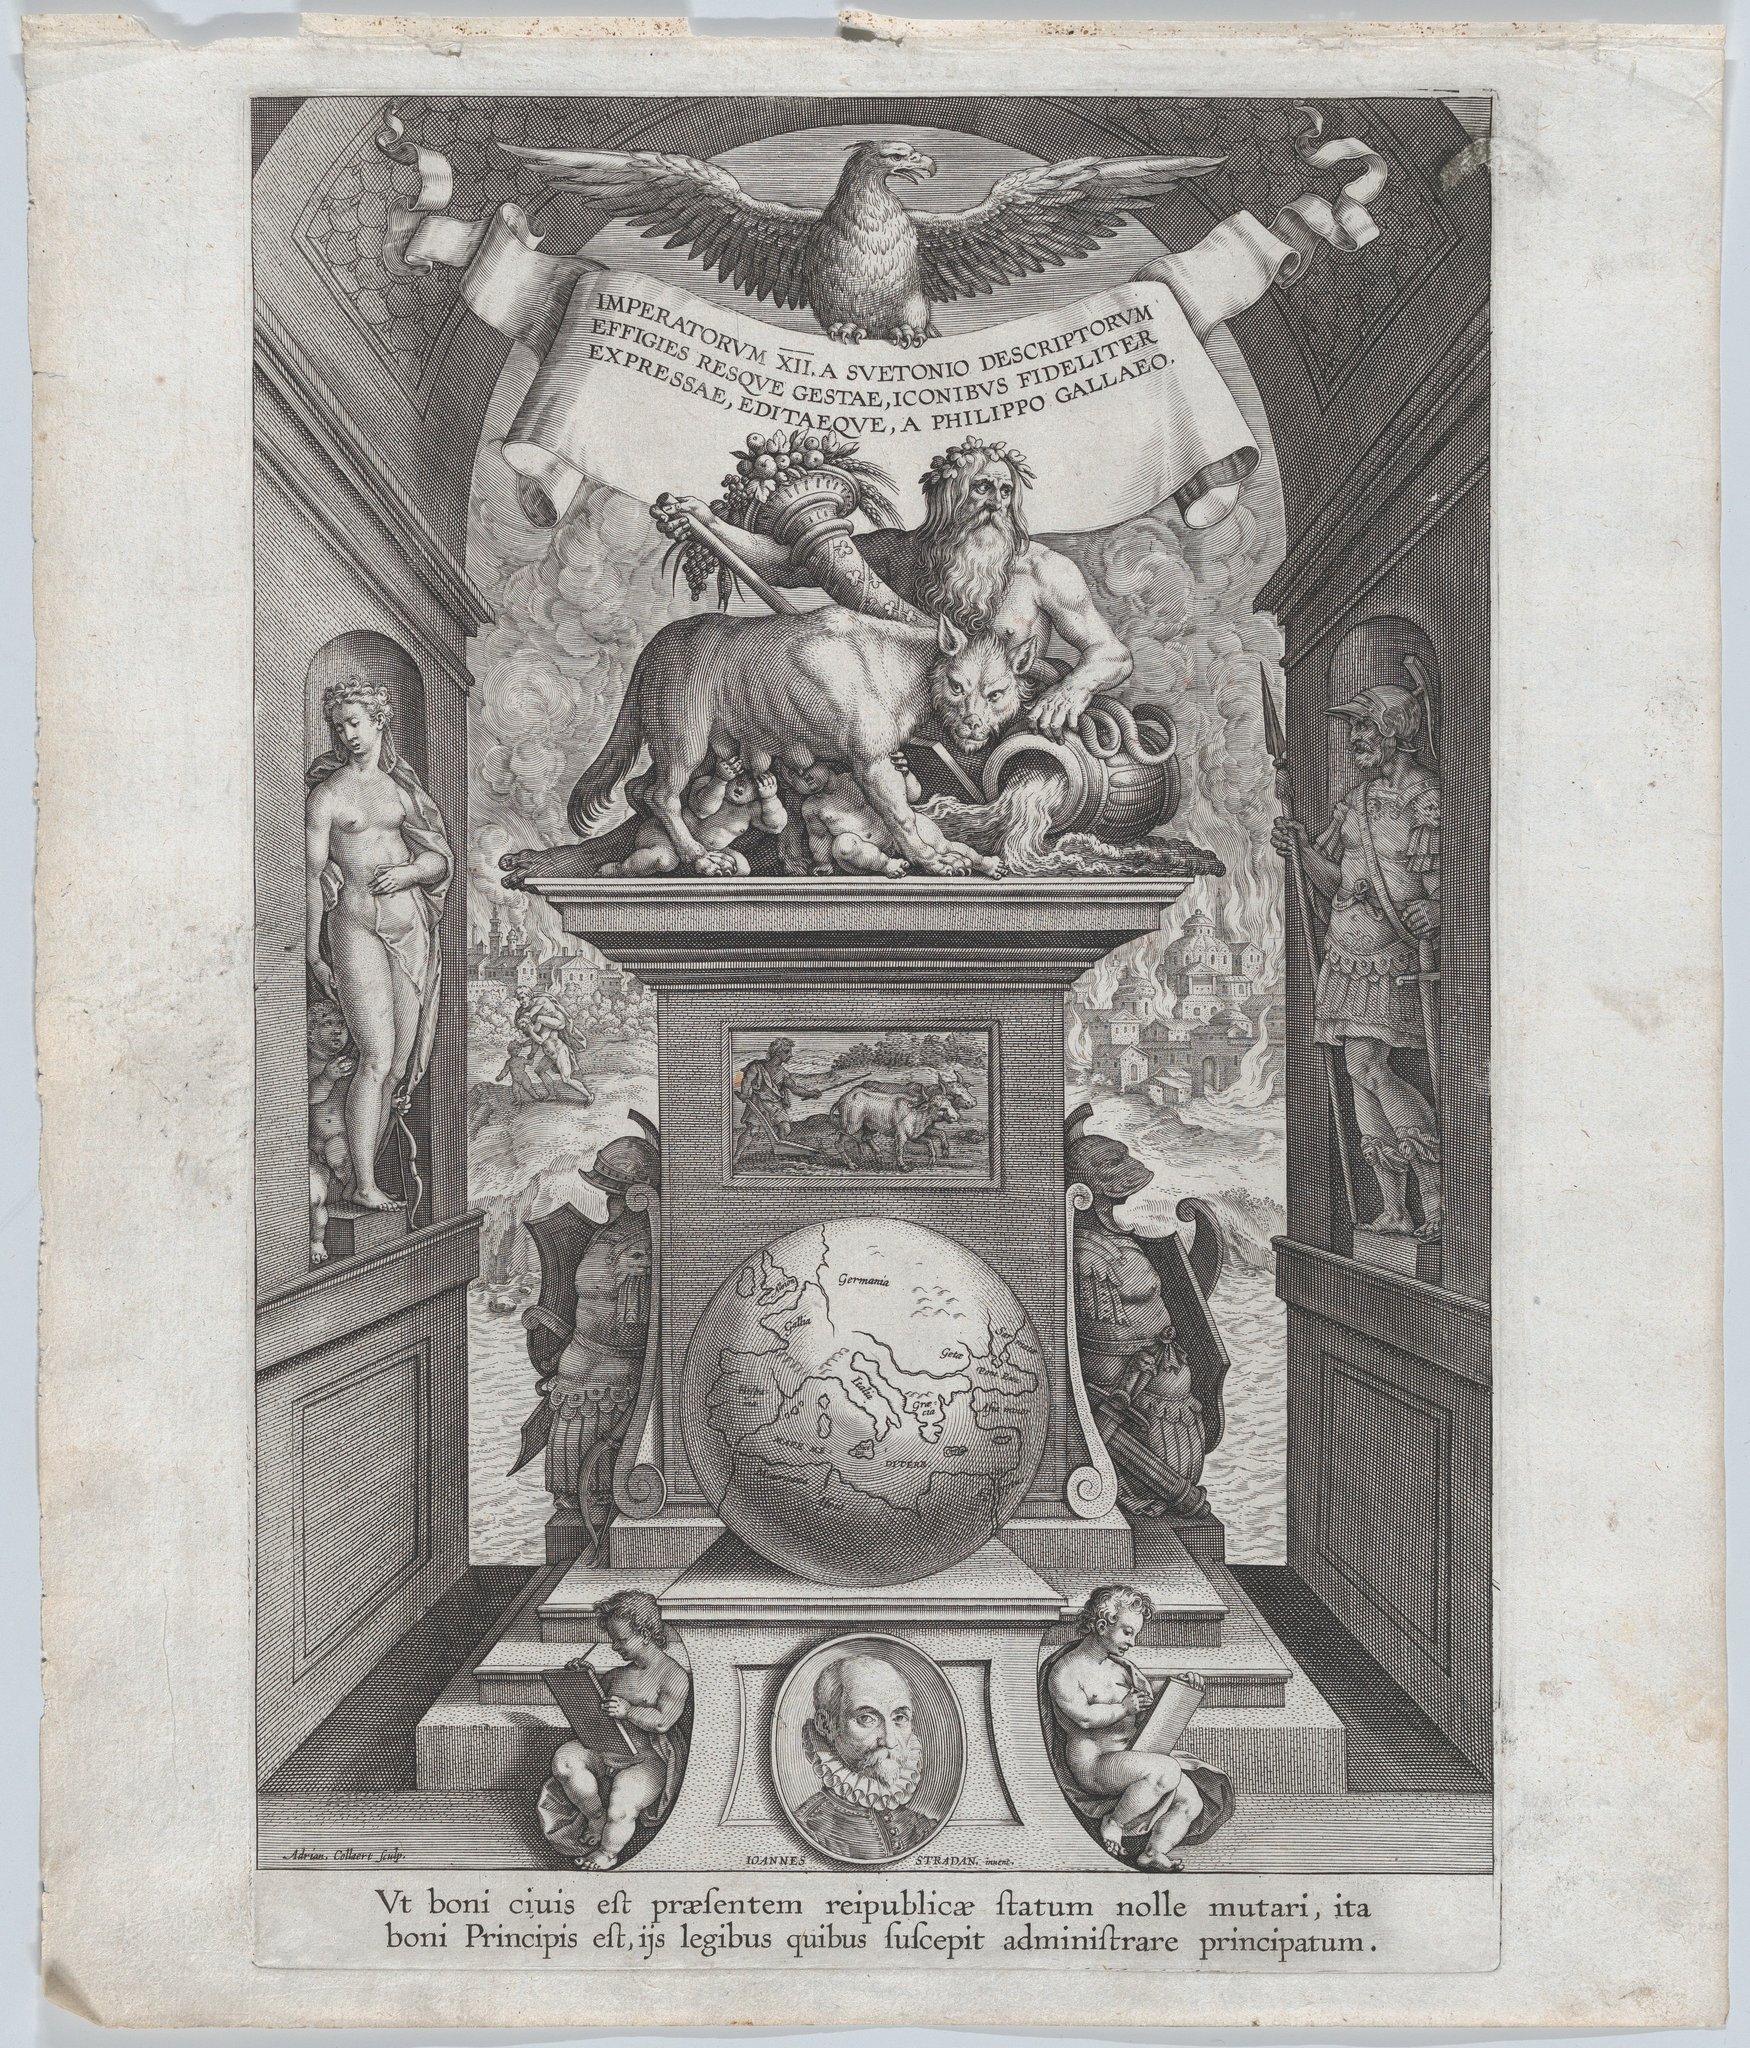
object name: print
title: Title page for "Roman Emperors on Horseback"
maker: adriaen collaert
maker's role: artist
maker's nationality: netherlandish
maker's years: 1560-1618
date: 1587-1589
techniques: engraving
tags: animals,eagles,men,portraits